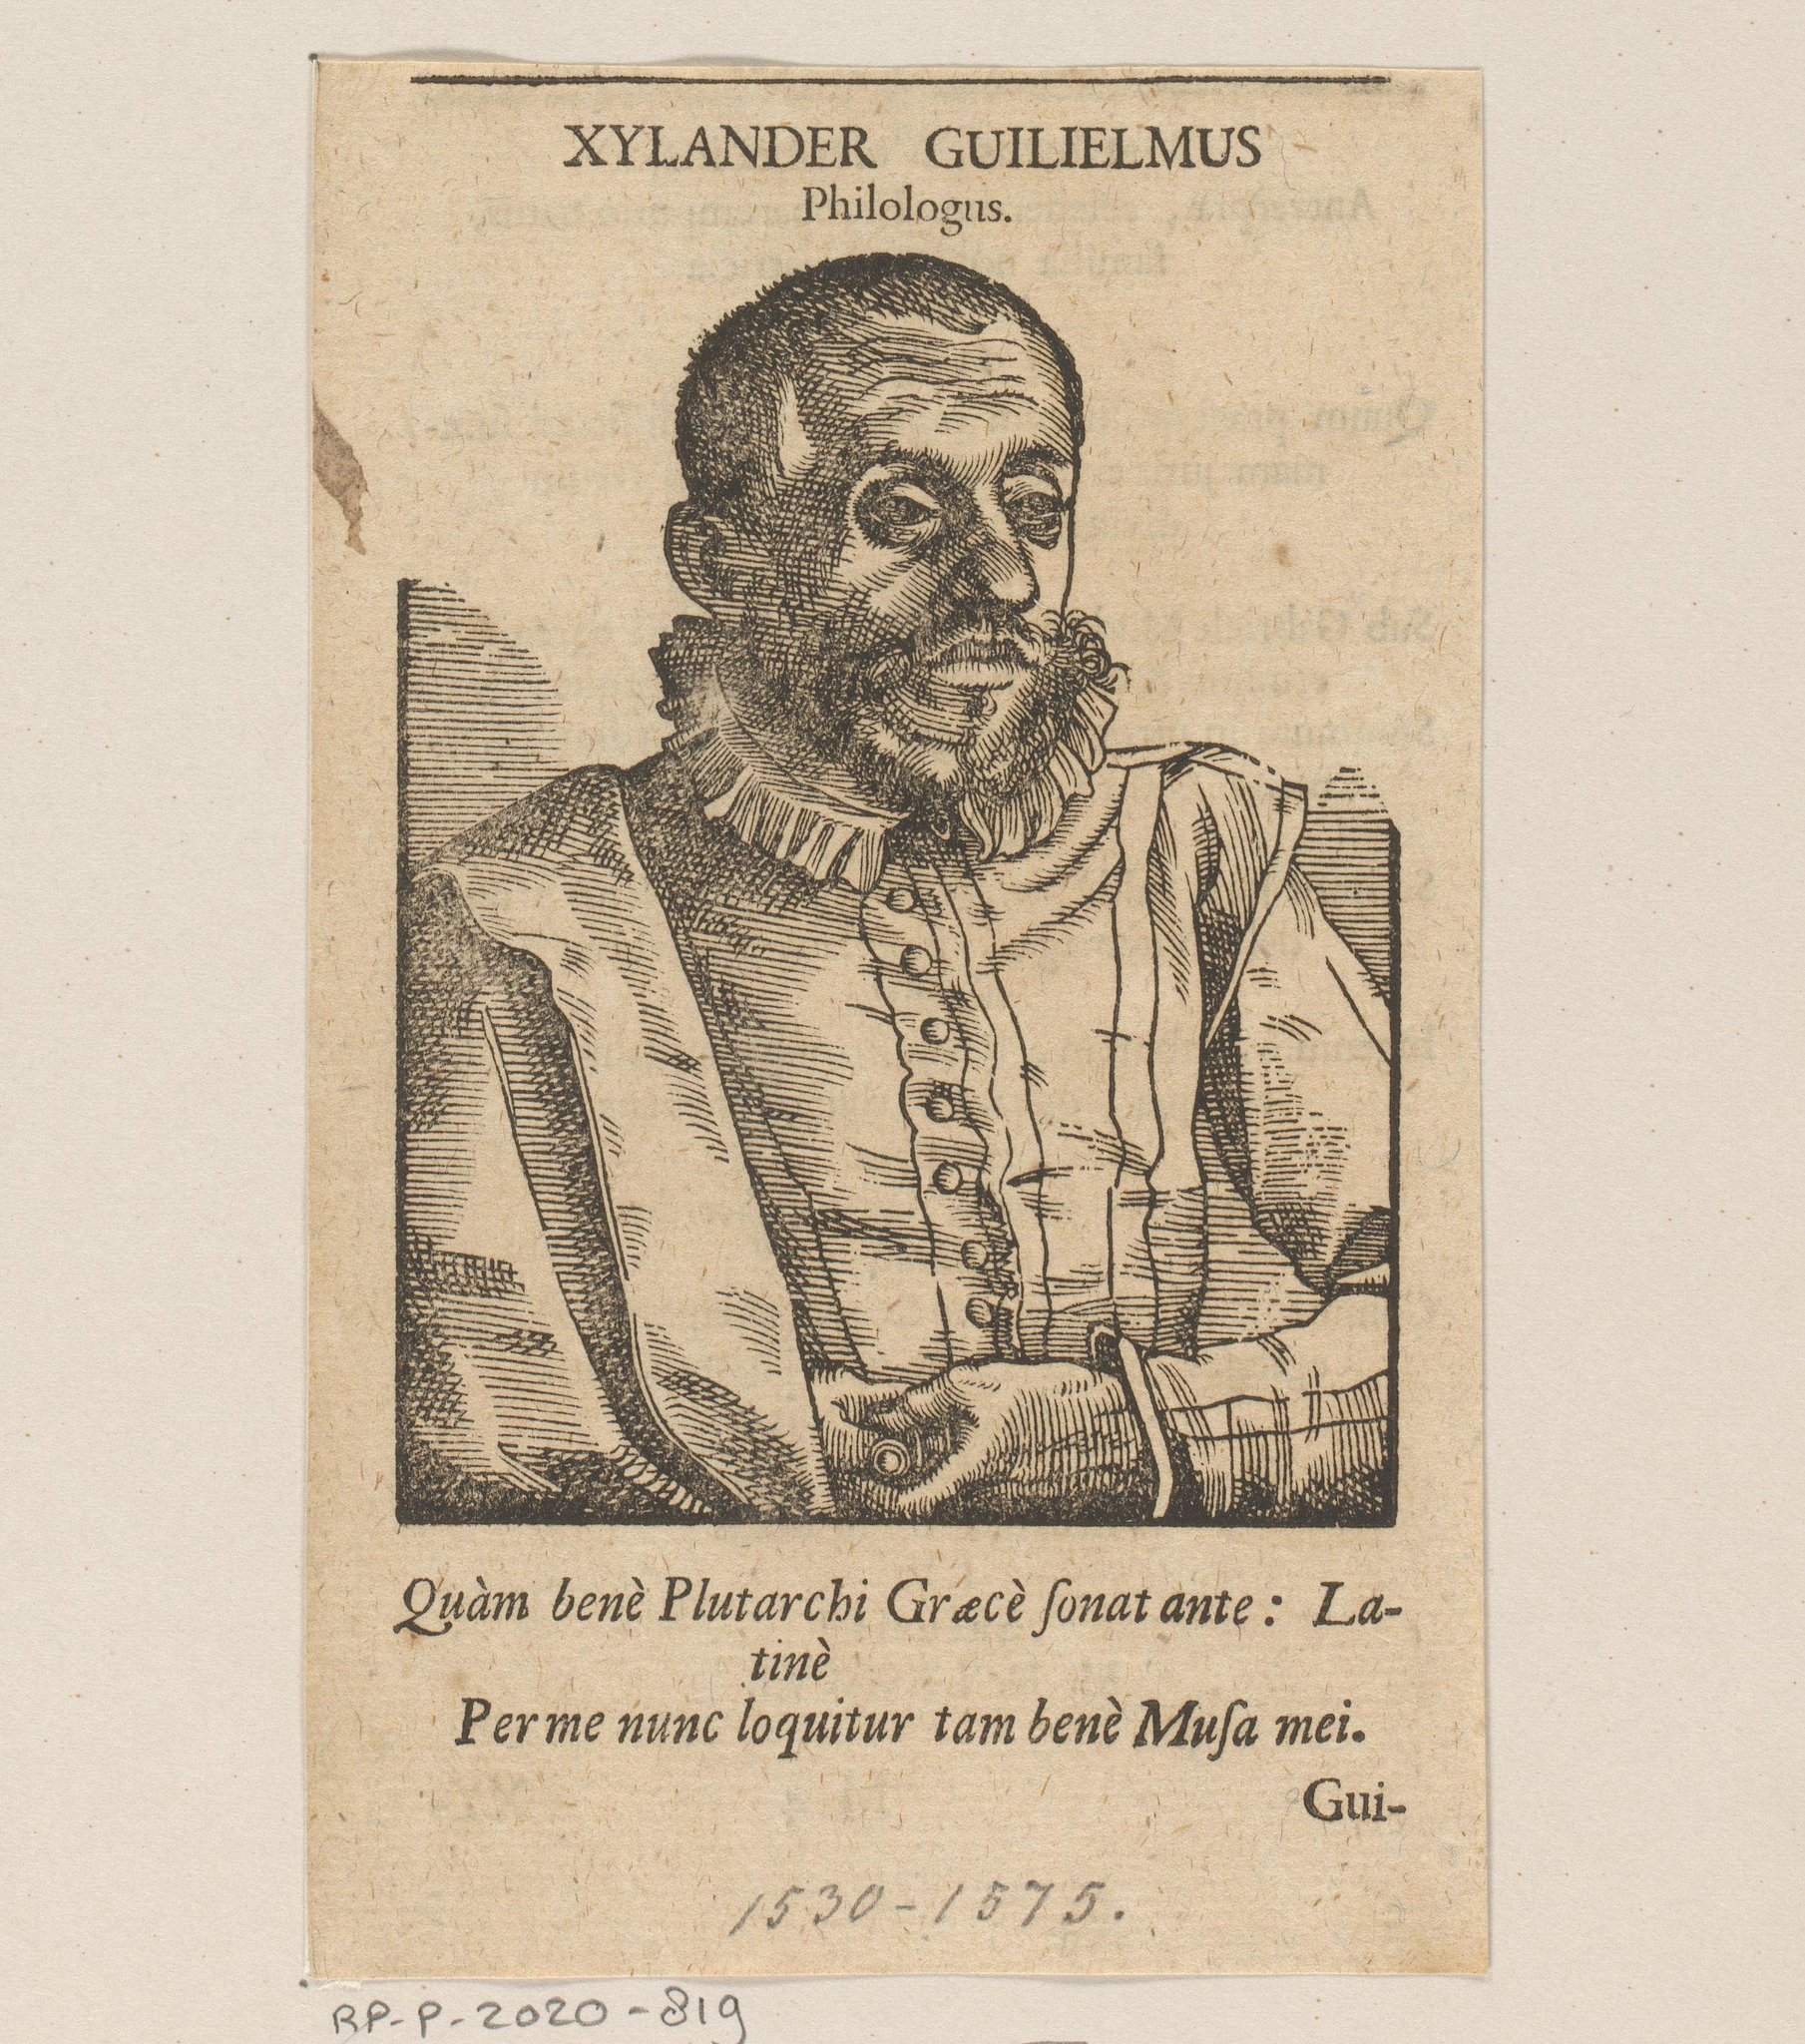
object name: print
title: Portret van Wilhelmus Xylander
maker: johann balthasar diehl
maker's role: printer, publisher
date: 1719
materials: paper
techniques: letterpress printing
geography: frankfurt am main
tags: augsburg, scholar, philosopher, historical persons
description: Prent uit: Reusner, Nikolaus. Icones sive imagines virorum literis illustrium qui seculo XV. (...). Frankfurt am Main: Johann Balthasar Diehl, 1719, p. 176. Prent voor het eerst verschenen in de eerste editie van 1587.